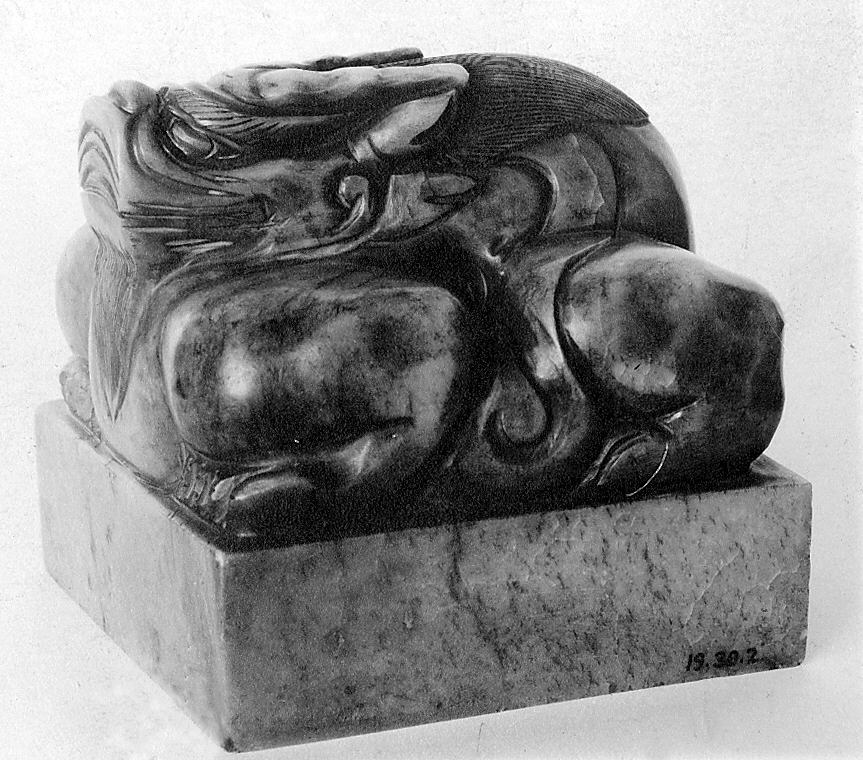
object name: seal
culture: chinese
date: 960-1279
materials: jade